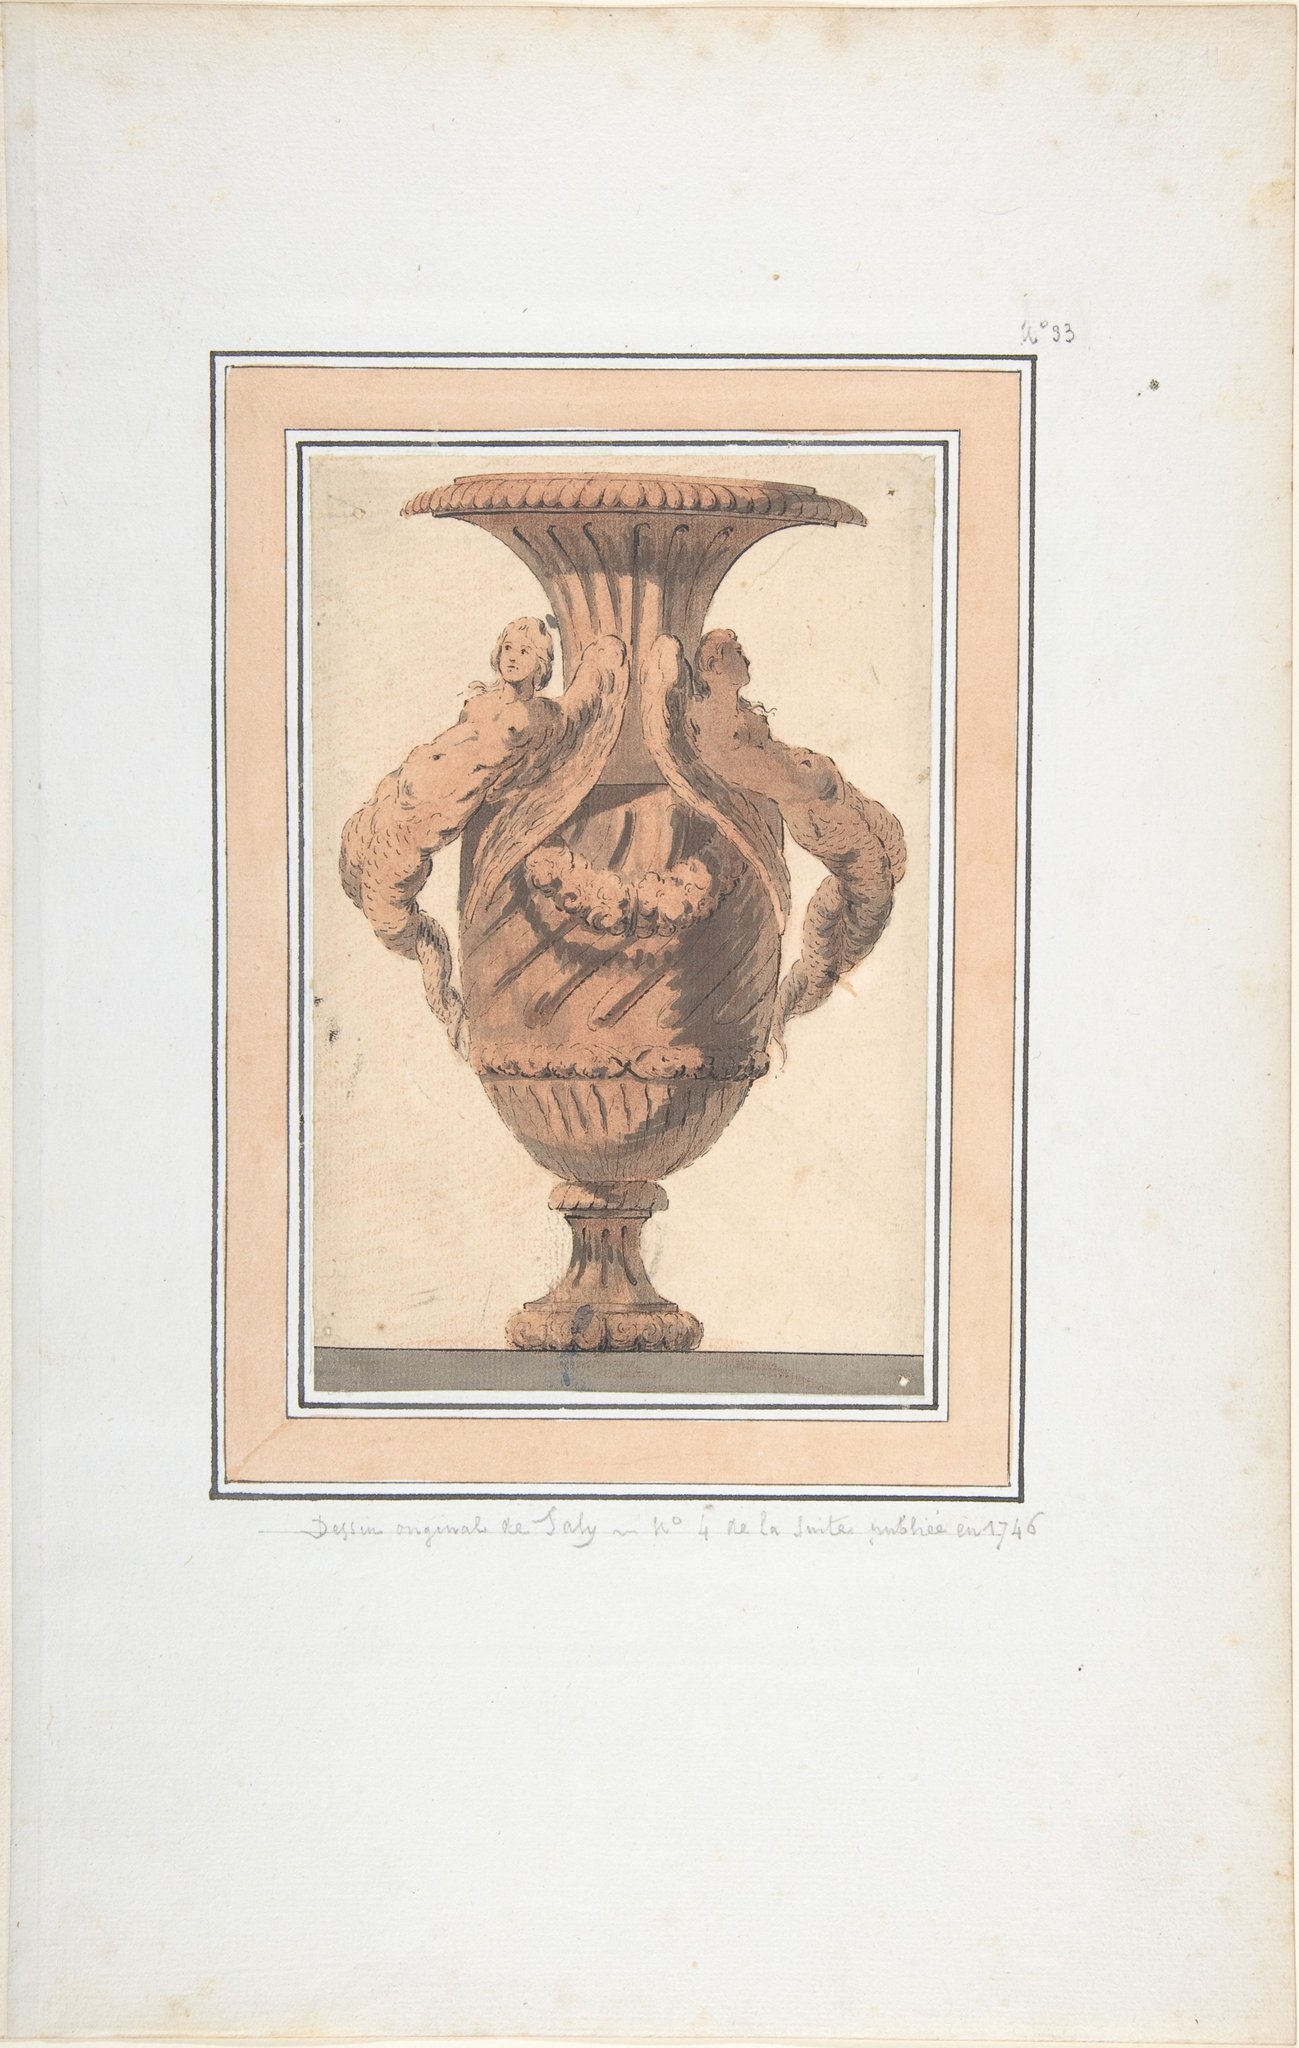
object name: drawing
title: Design for Vase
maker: jacques françois joseph saly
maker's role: artist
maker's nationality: french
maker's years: 1717-1776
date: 1734-1766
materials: ink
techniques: brush, pen, wash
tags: mermaids,vases